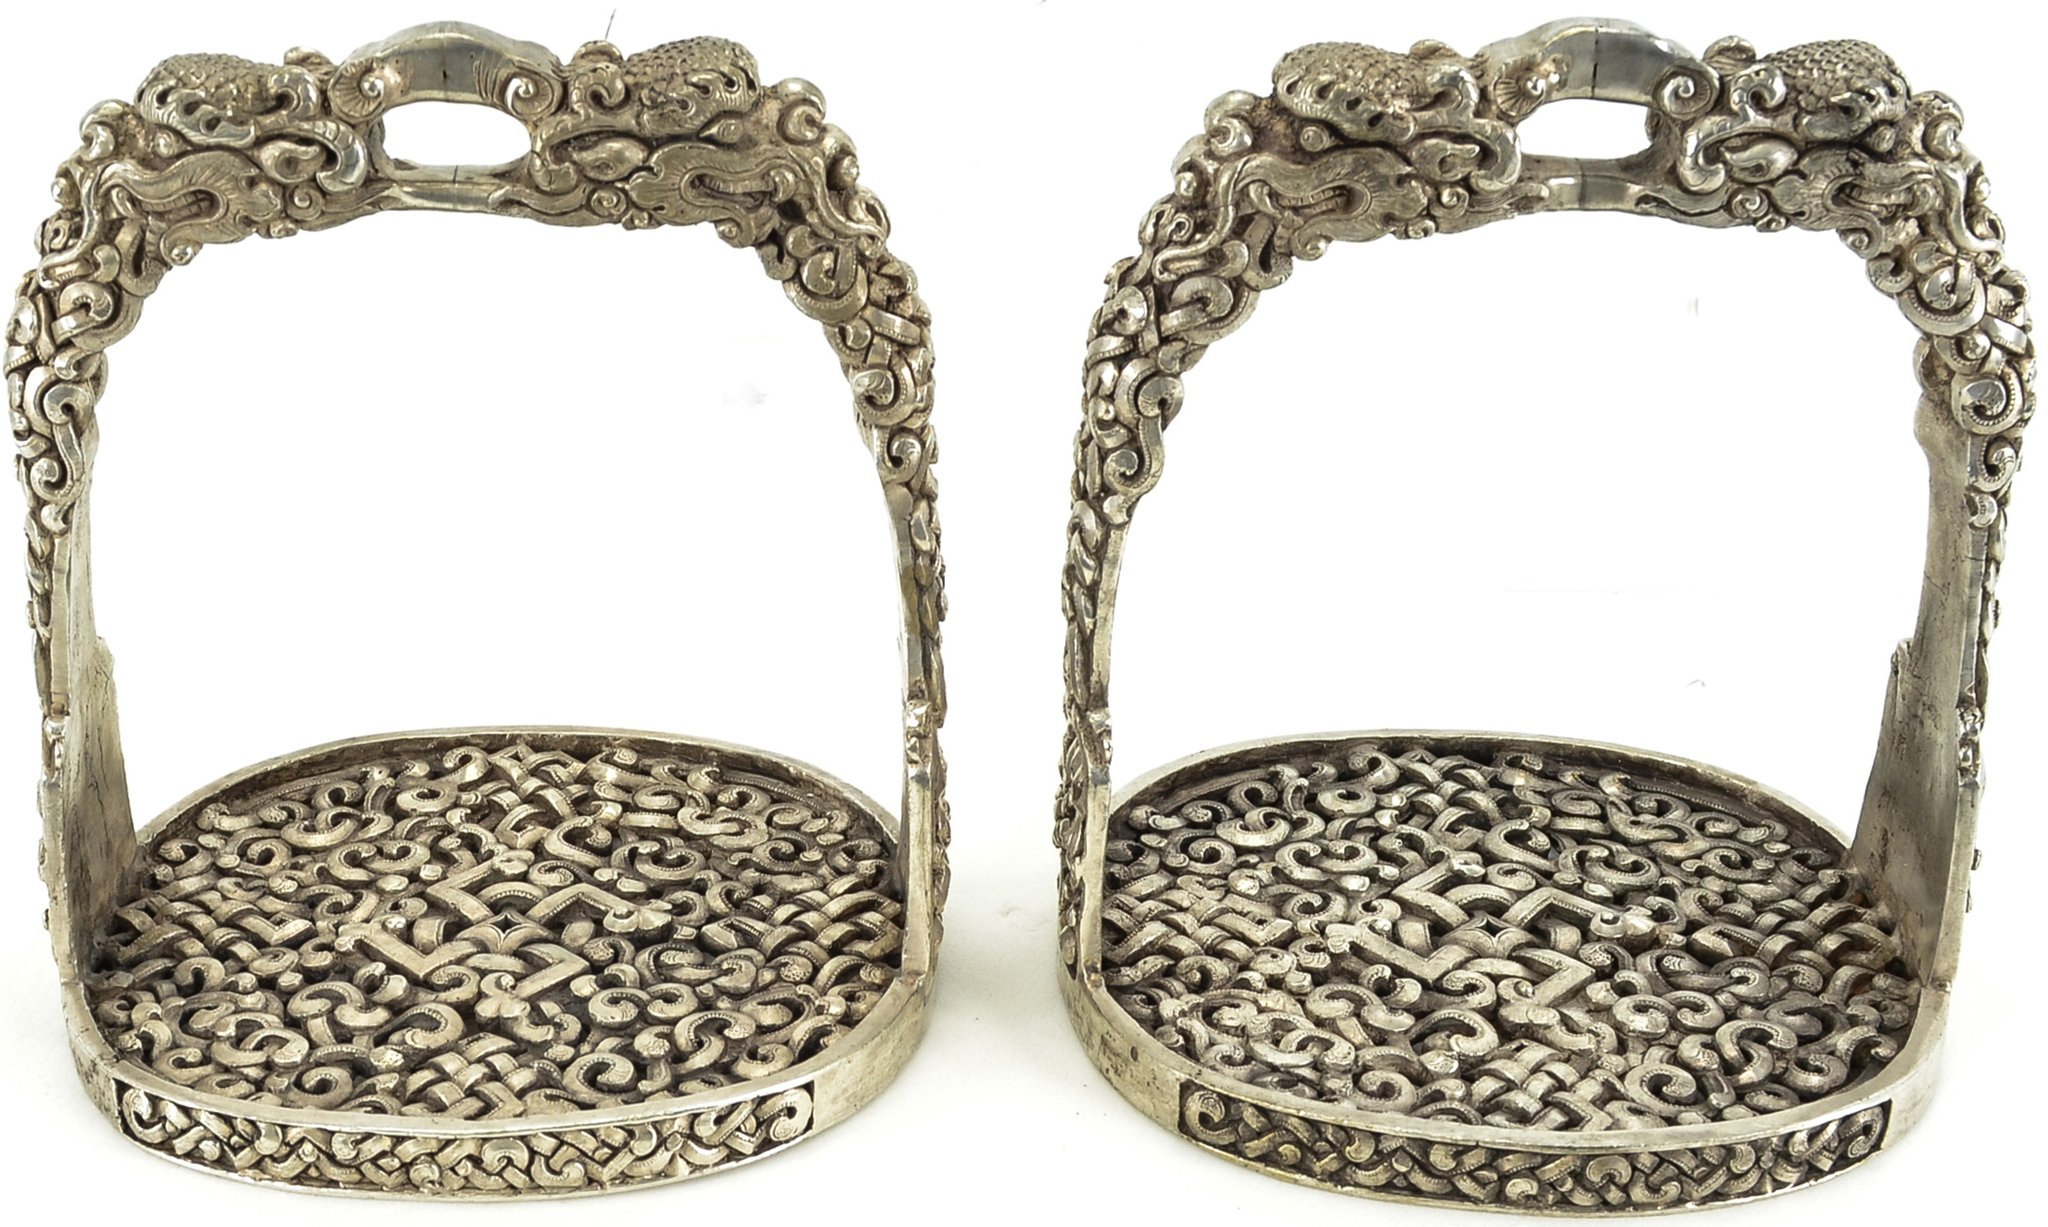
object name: pair of stirrup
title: Pair of Stirrups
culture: mongolian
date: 1767-1866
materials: silver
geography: mongolia